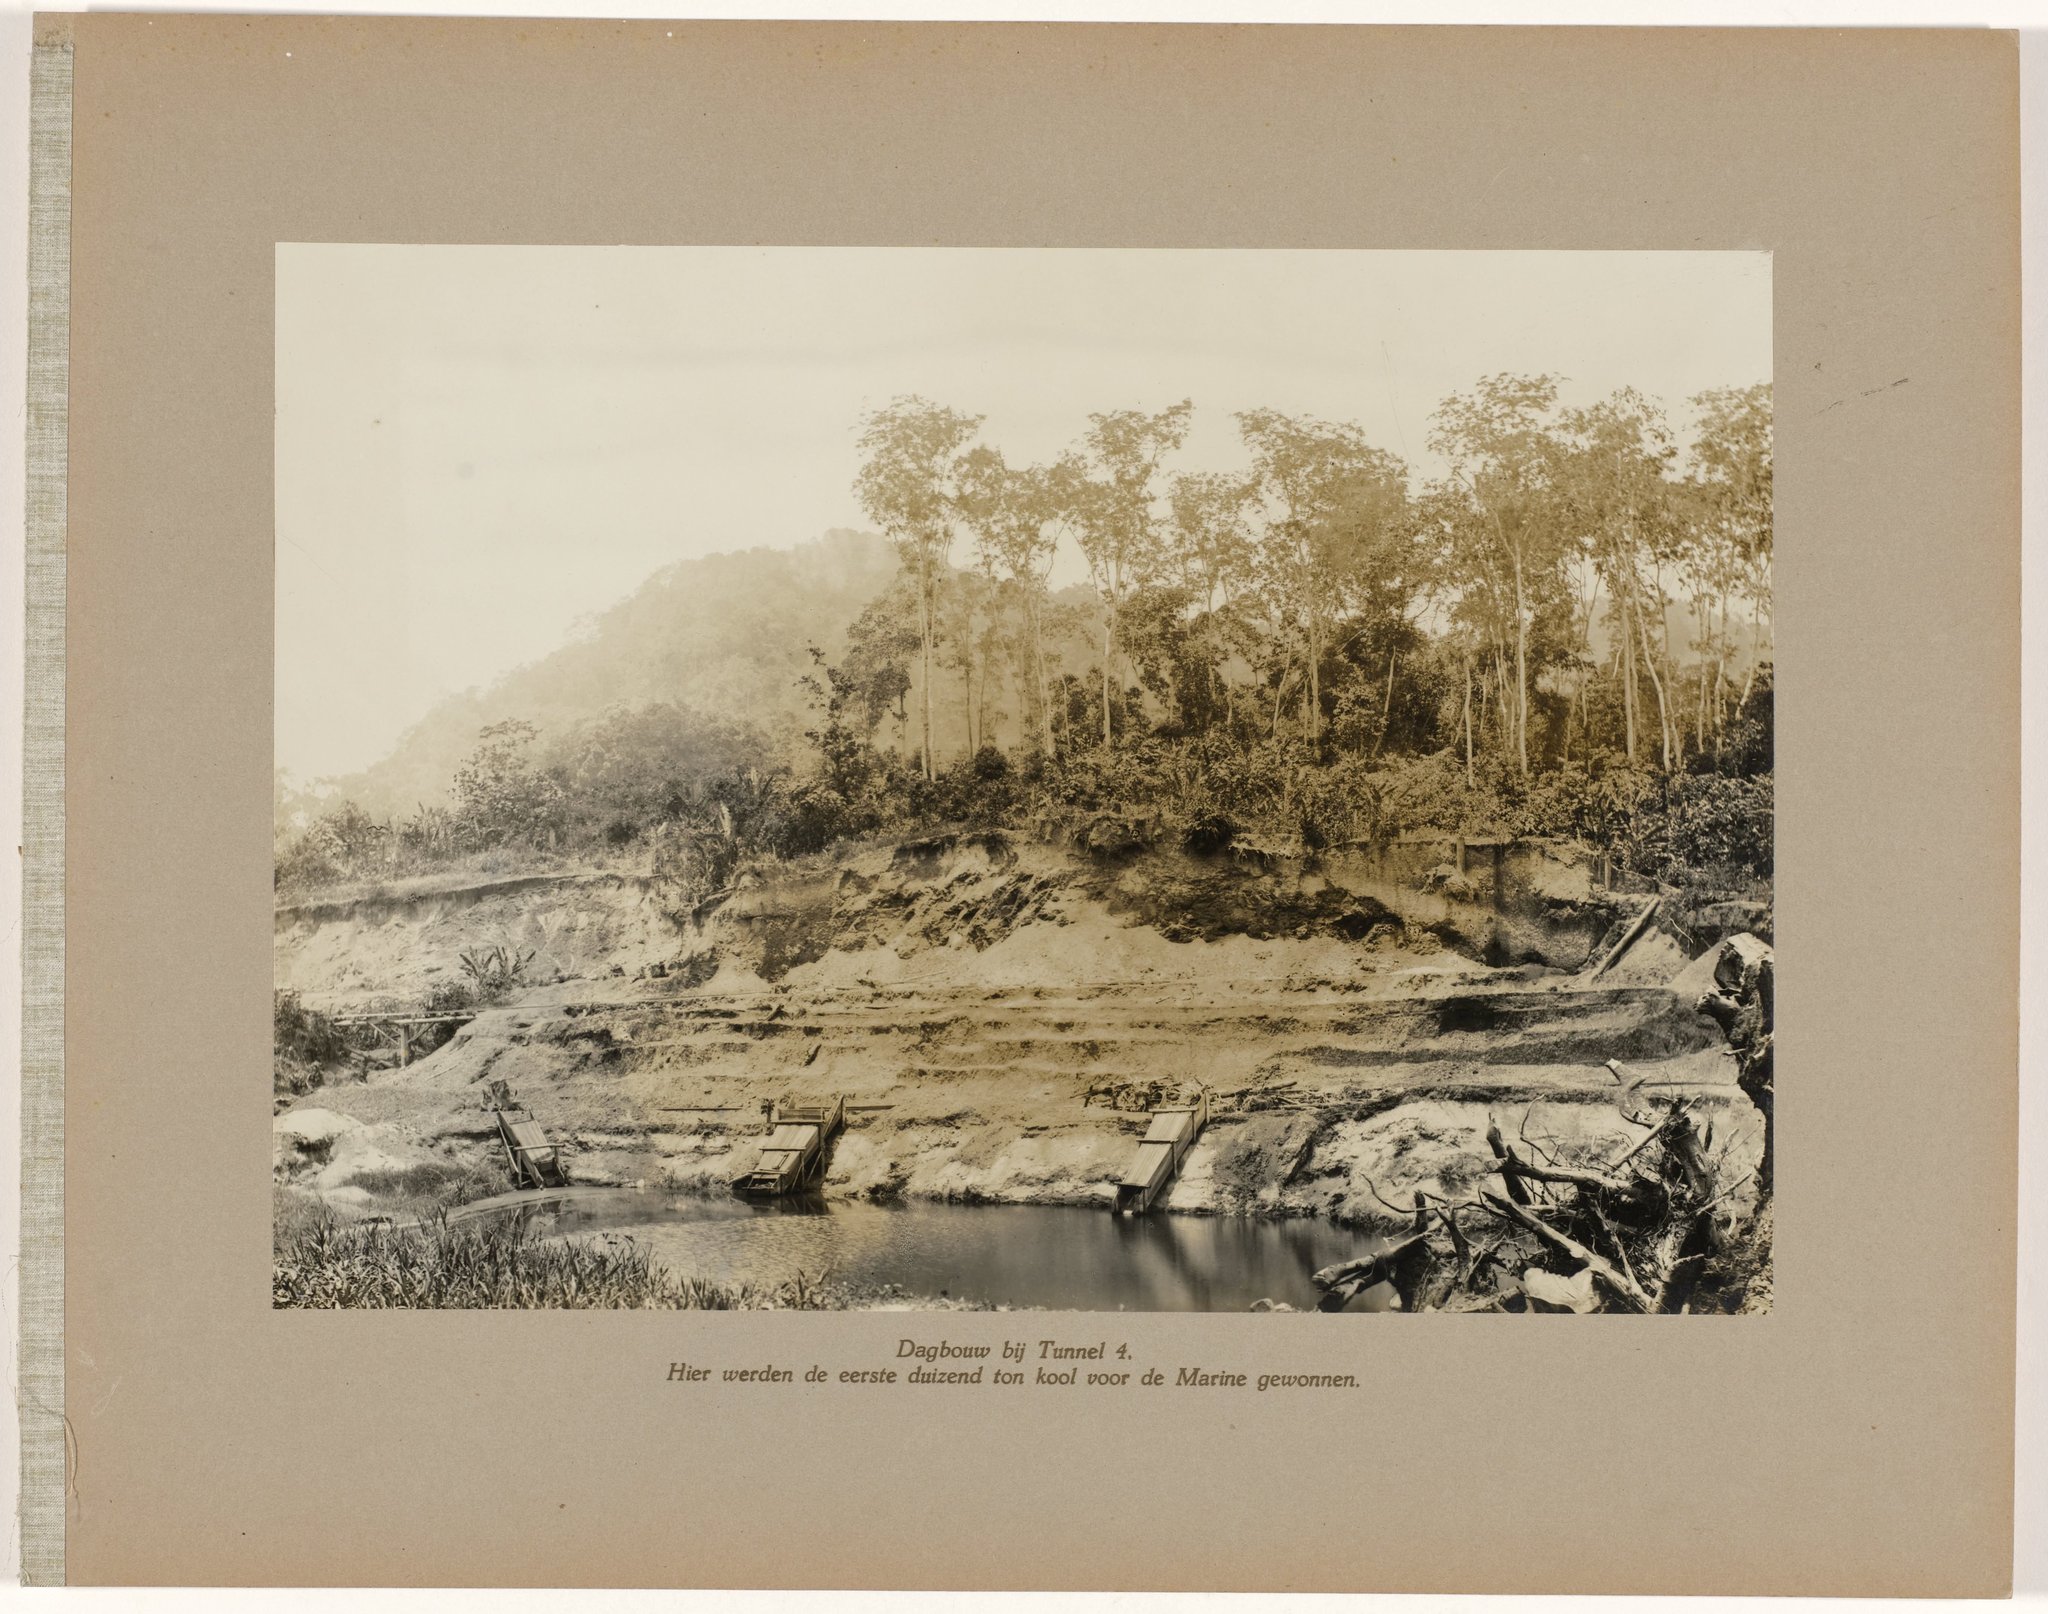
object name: photograph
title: Dagbouw bij Tunnel 4. Hier werden de eerste duizend ton kool voor de Marine gewonnen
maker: Anonymous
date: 1921-1922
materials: photographic support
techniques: gelatin silver print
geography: bukit asam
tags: colonial system, mining, anthracite, hard coal, opencast mine; strip mining (+ coal), sumatra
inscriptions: inscription: ‘Dagbouw bij Tunnel 4. Hier werden de eerste duizend ton kool voor de Marine gewonnen.’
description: Steenkoolwinning in een open mijn (dagbouw). Gezicht op de blootliggende en deels afgegraven koollaag. Onderdeel van het losbladige fotoalbum aangeboden door het personeel van de Boekit-Asam Steenkolenmijnen op Sumatra aan de scheidende Ingenieur-Directeur H. Tromp op 7 januari 1922.